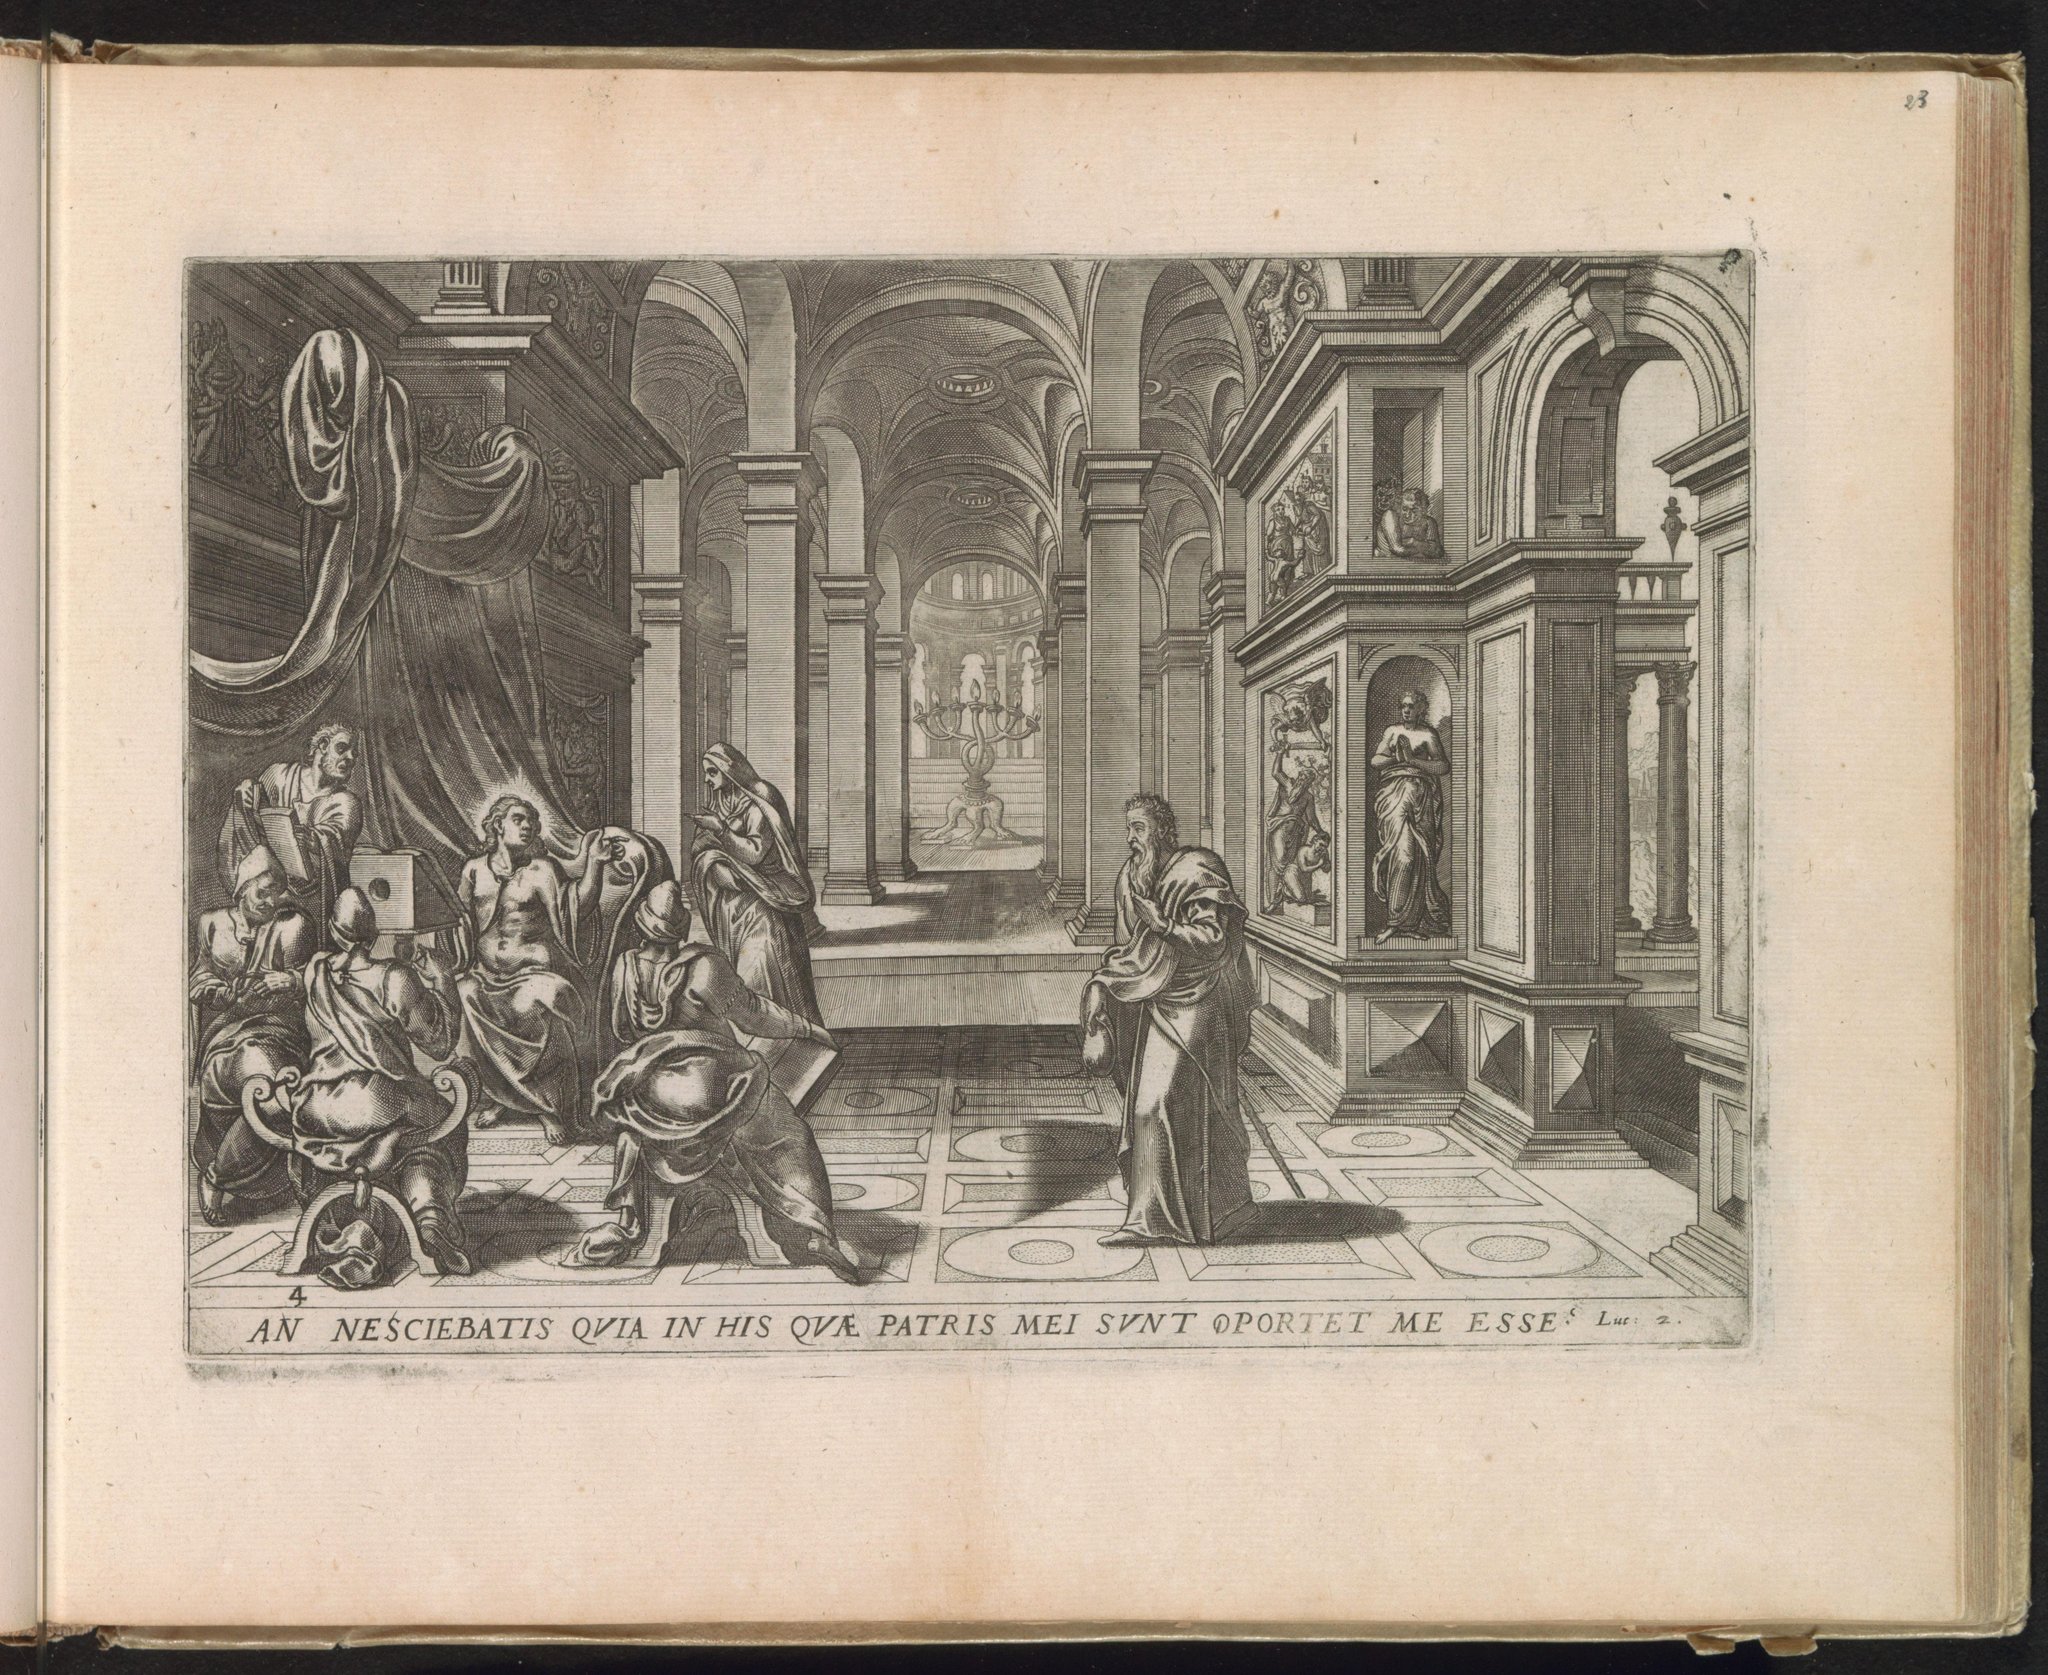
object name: album leaf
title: Gebeurtenissen in en rond de tempel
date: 1585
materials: paper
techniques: engraving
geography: antwerp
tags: christ's dispute with the doctors in the temple; he counts his arguments on his fingers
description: In een hoek van de tempel zit Christus tussen de schriftgeleerden en legt hen de schrift uit. Christus maakt een spreekgebaar. Jozef loopt de tempel binnen en vindt zijn zoon tussen de geleerden. Onder de voorstelling een verwijzing in het Latijn naar de Bijbeltekst in Luc. 2. Deze prent maakt deel uit van een album.